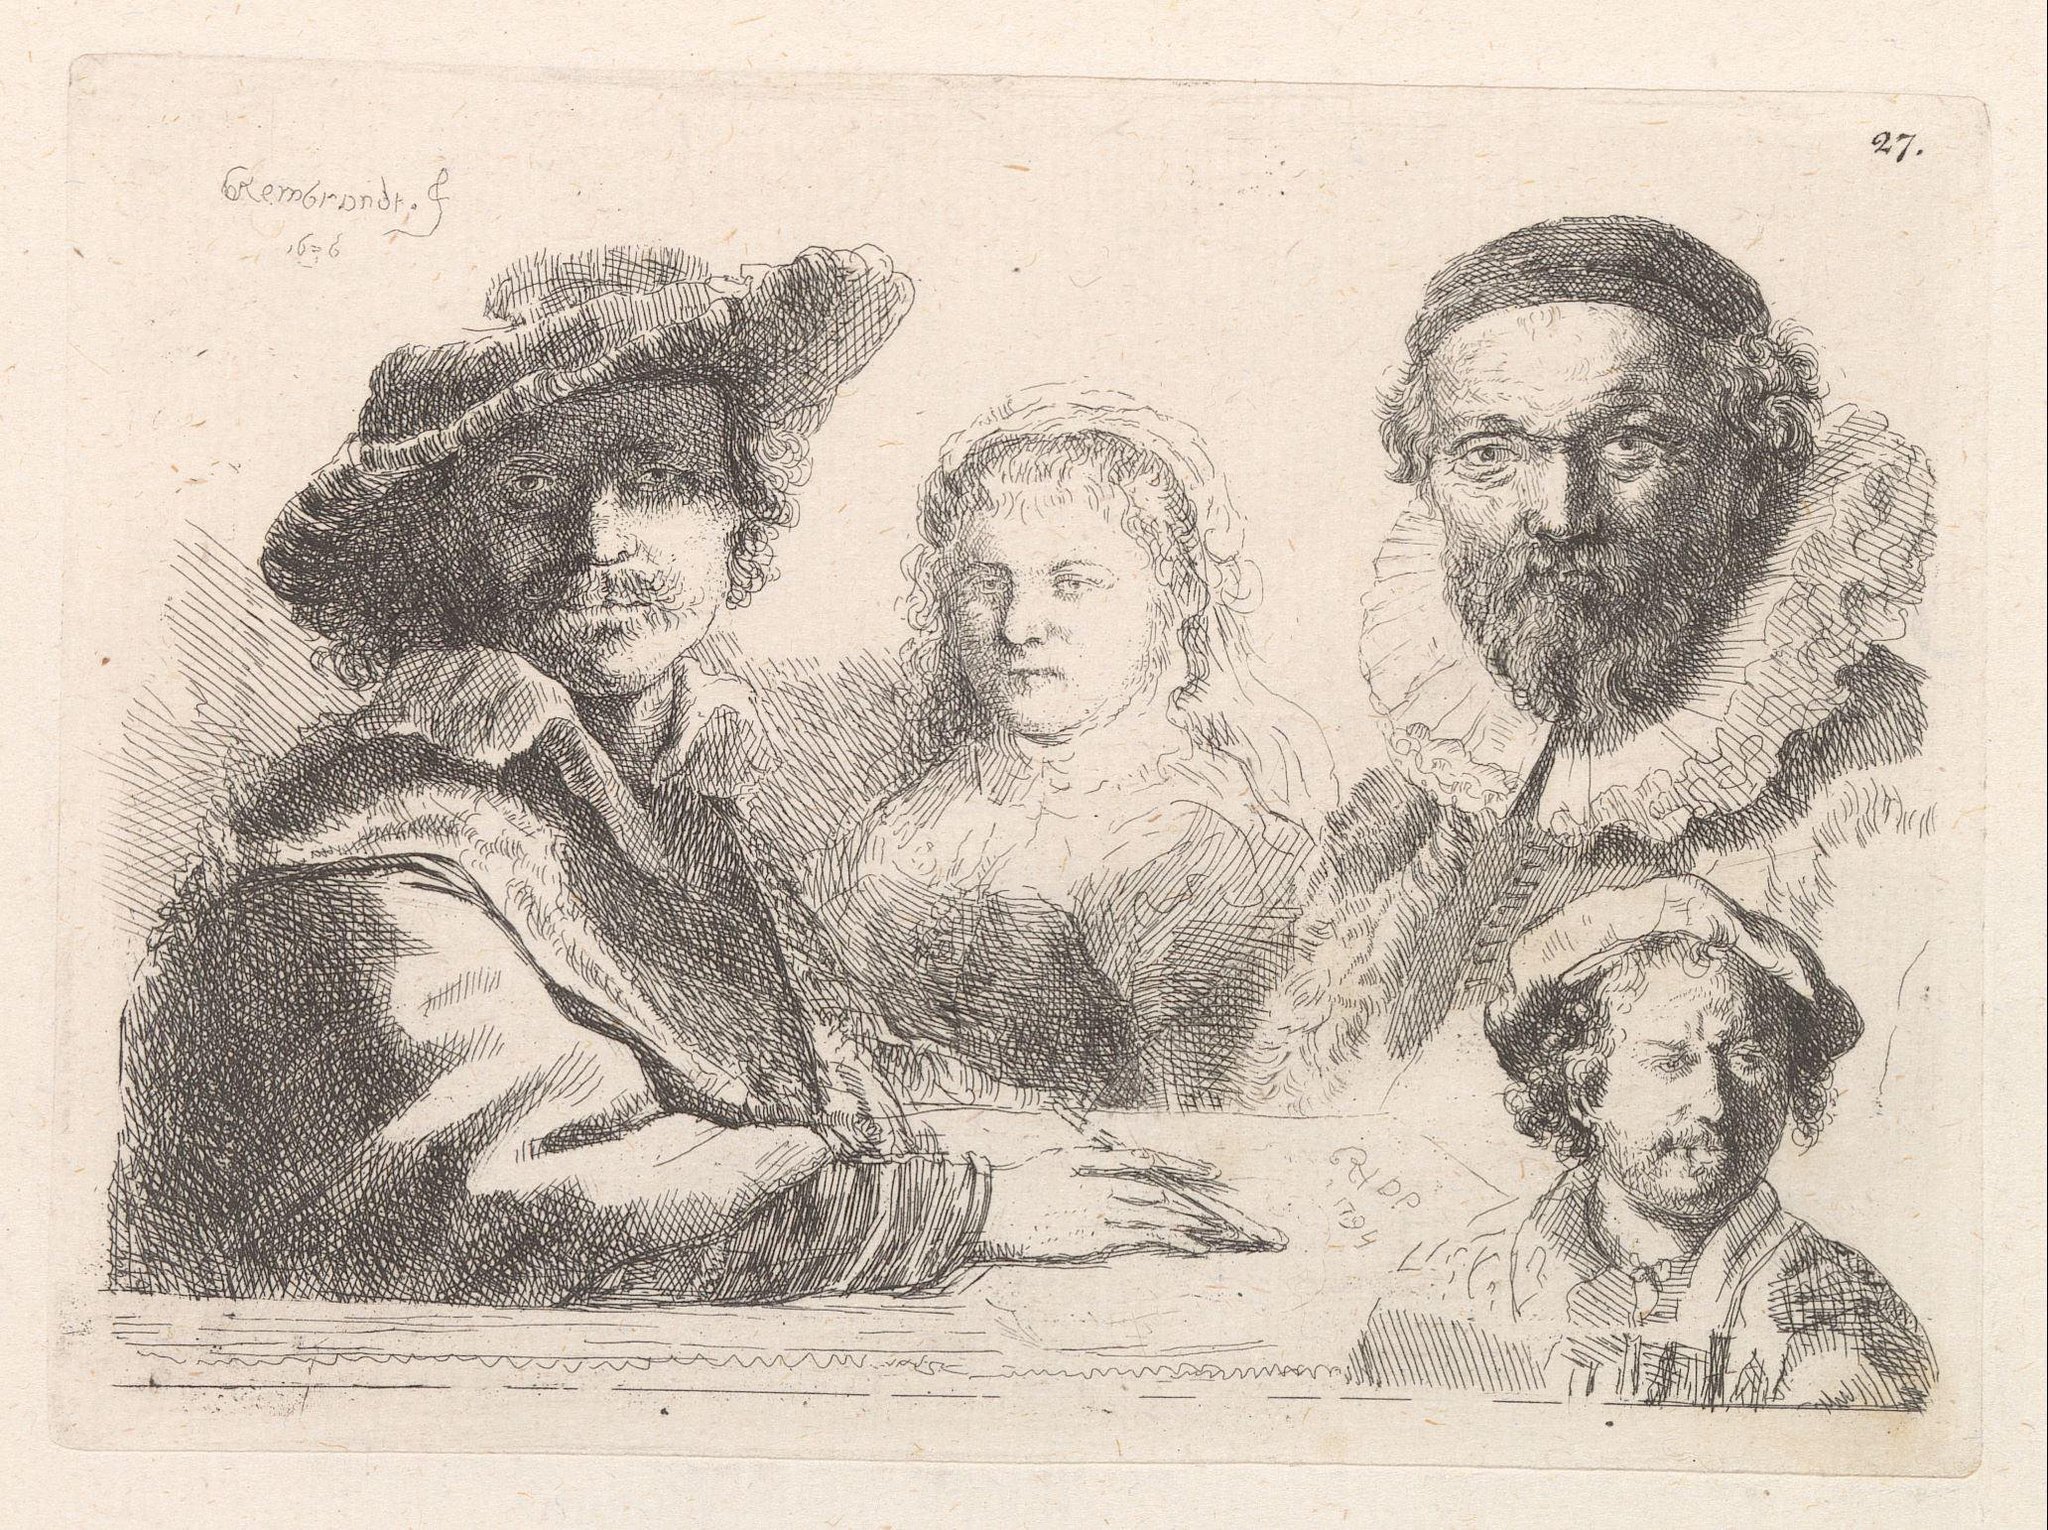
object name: print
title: Self-portrait with Saskia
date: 1794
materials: paper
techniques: etching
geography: italy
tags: leiden, amsterdam, painter, print maker, draughtsman, rembrandt van rijn, utrecht, the hague, portrait, self-portrait of graphic artist